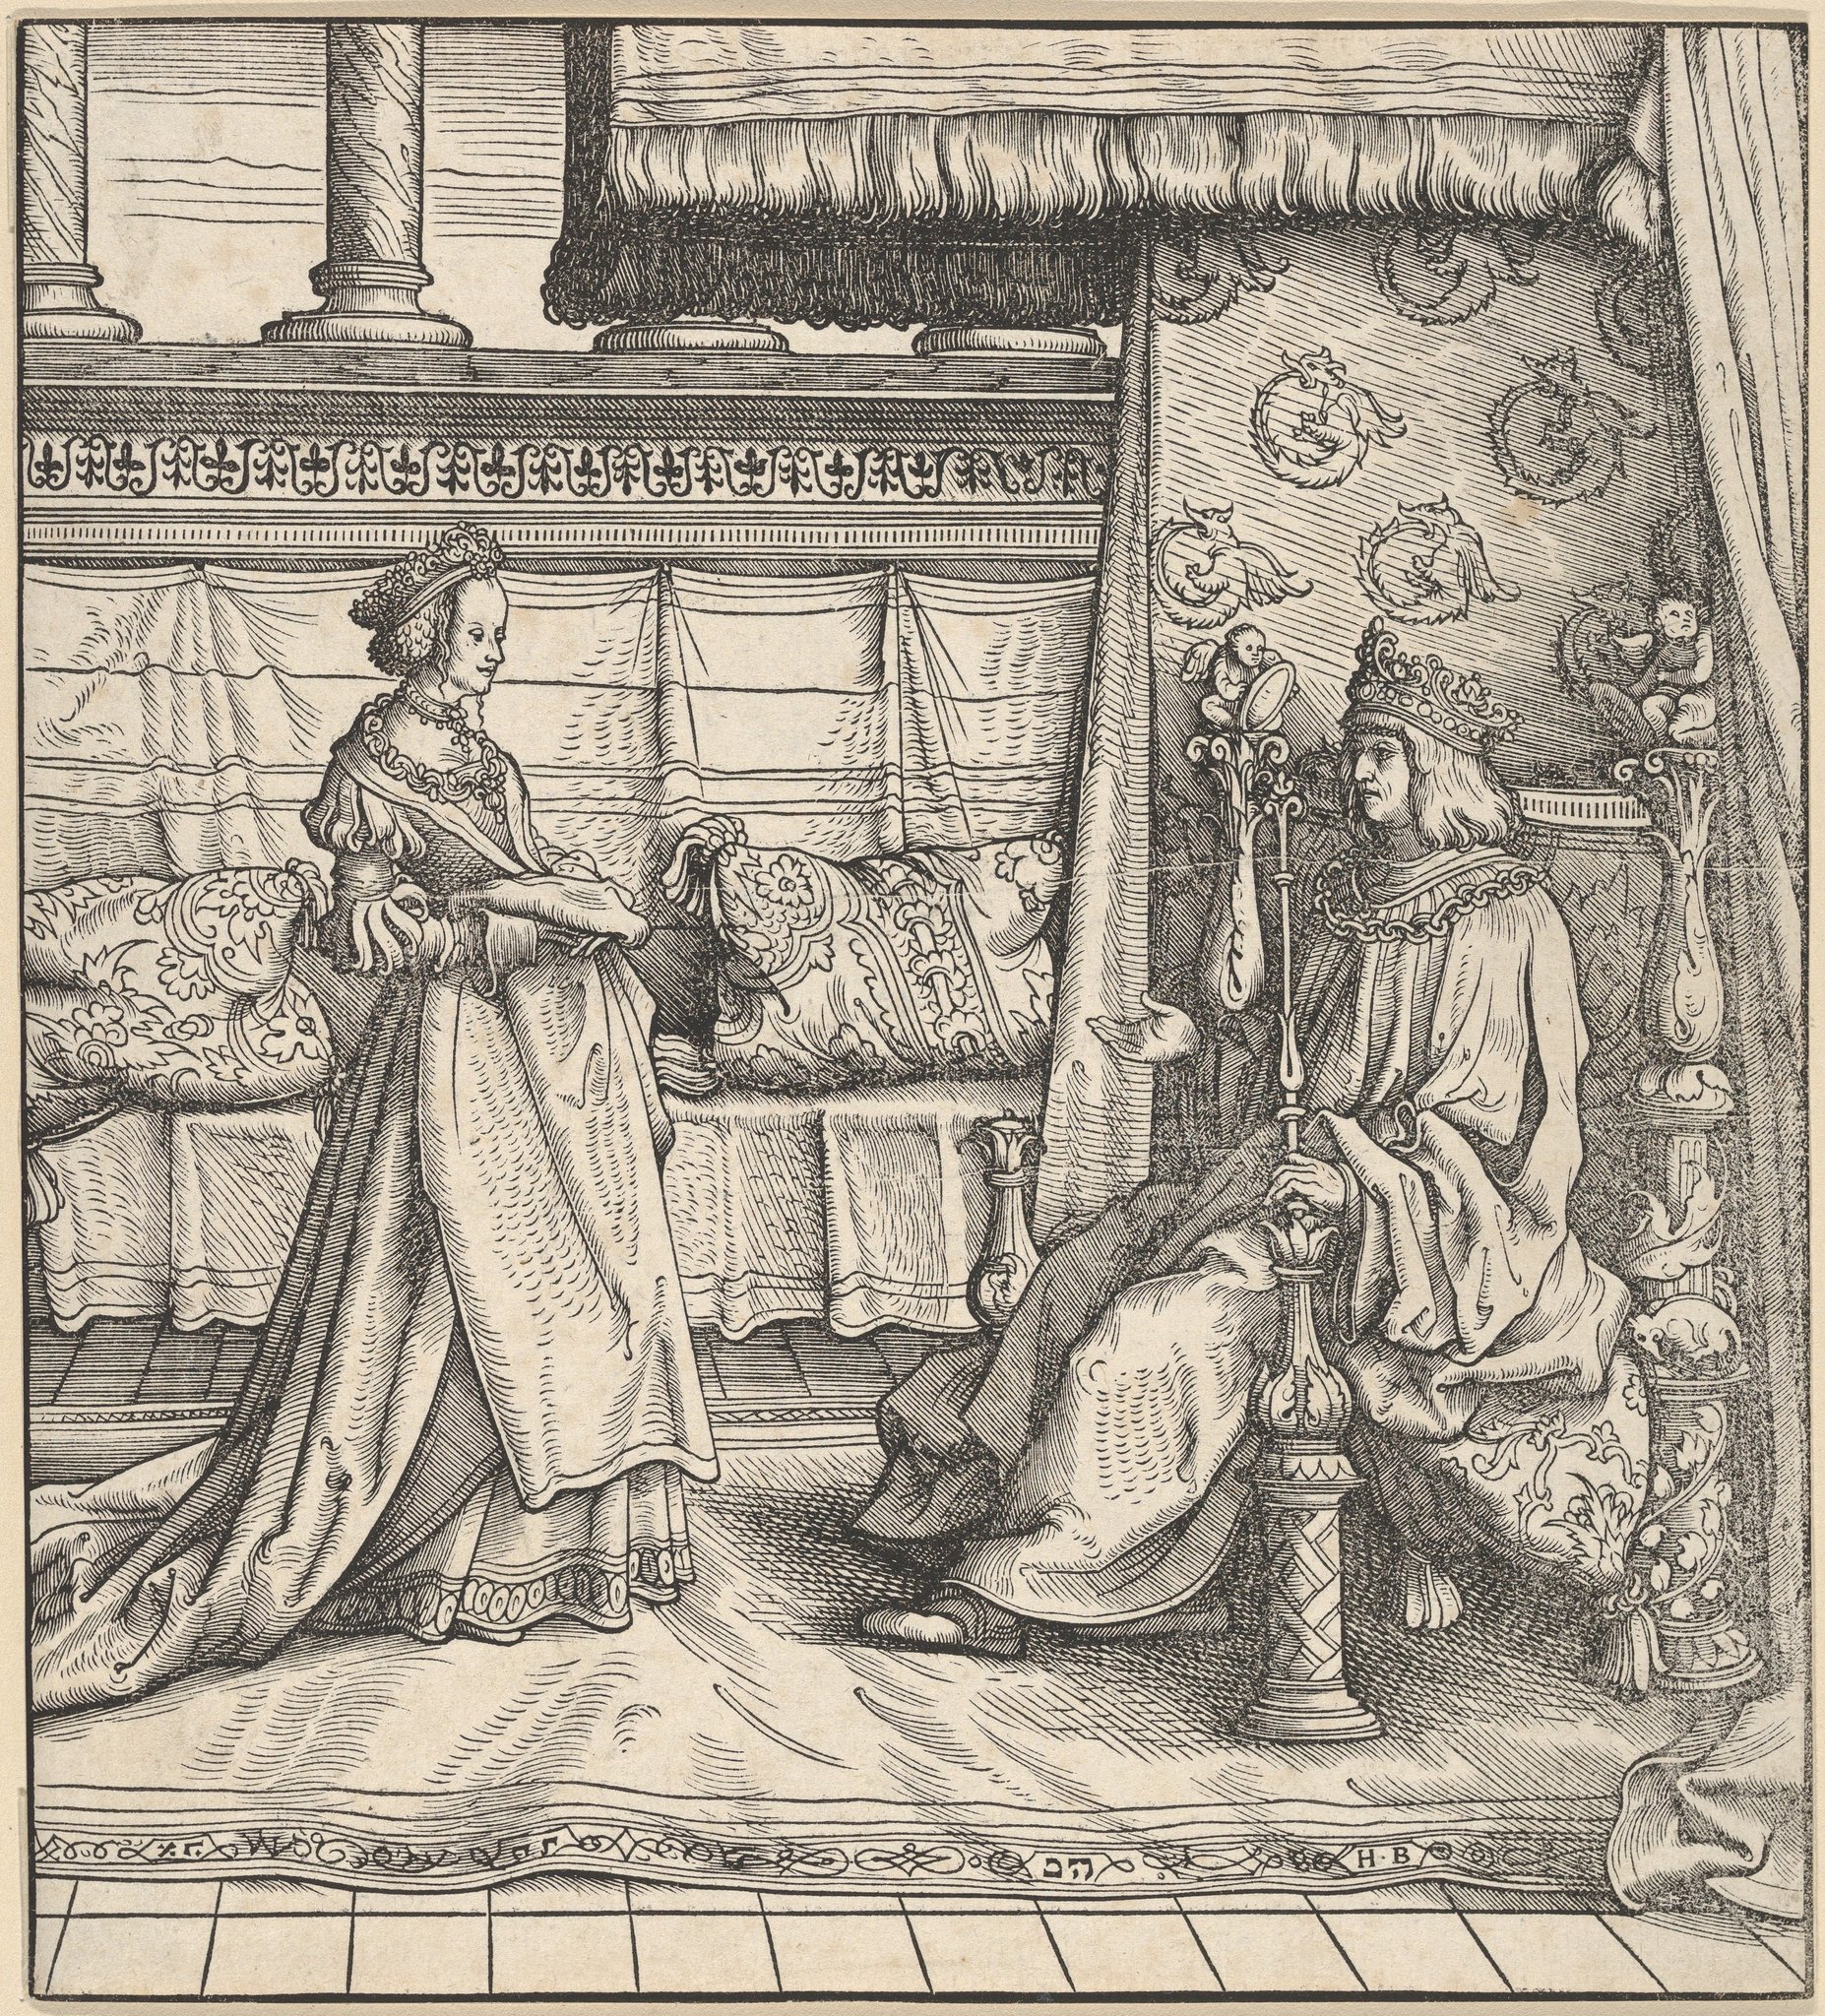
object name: print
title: The King of Feuereisen and His Only Daughter, from "Der Weisskunig"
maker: hans burgkmair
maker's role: artist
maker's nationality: german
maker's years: 1473-1531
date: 1501-1600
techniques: woodcut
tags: kings,men,women